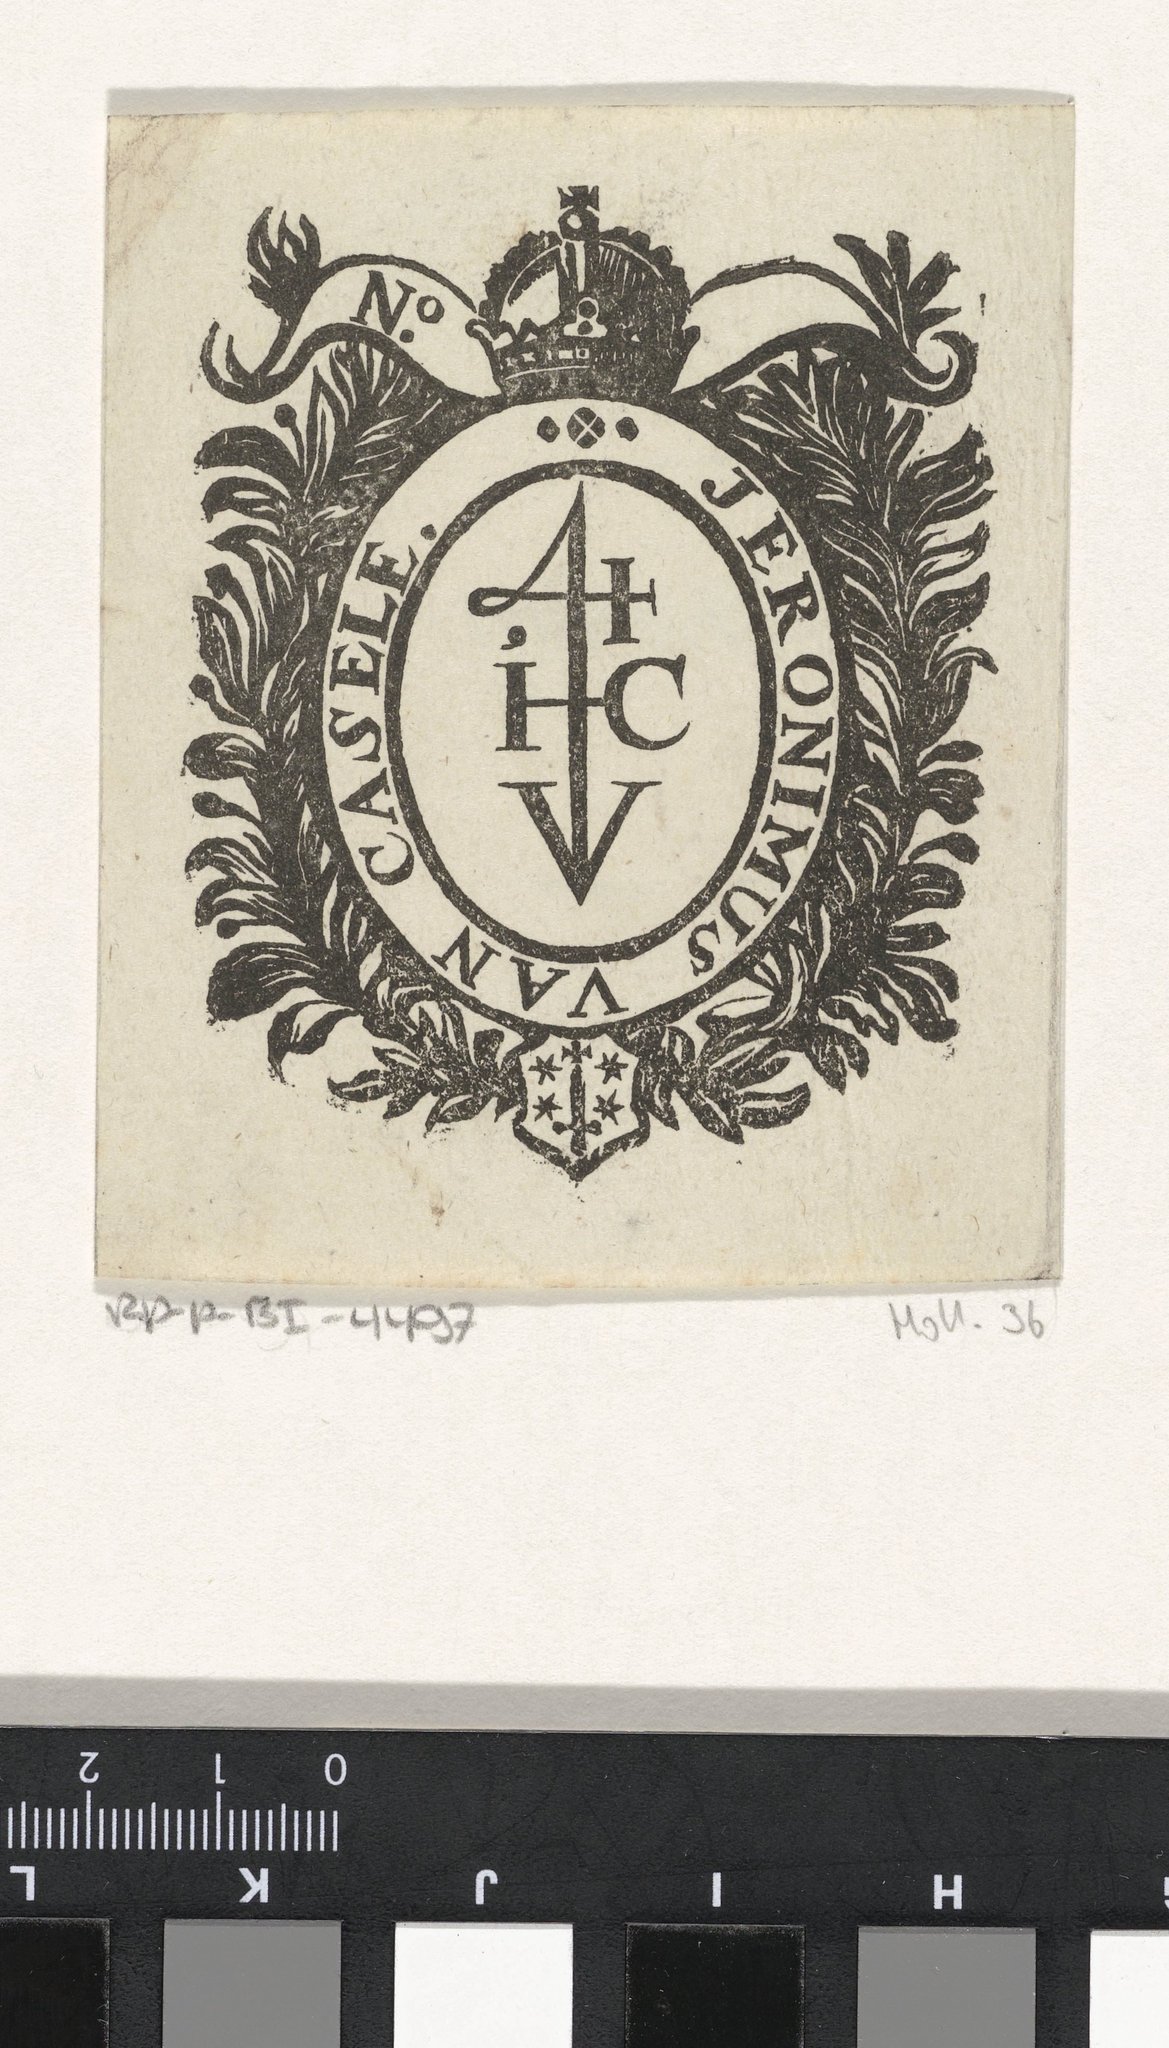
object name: handelsetiket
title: Handelsetiket van Jeronimus van Casele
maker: isaac vincentsz. van der vinne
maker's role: draughtsman, print maker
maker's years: 1665-1740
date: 1681-1740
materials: paper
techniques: woodcut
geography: haarlem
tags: coat of arms (as symbol of the state, etc.) (+ city; municipal), crown (symbol of sovereignty), vignette, letter combinations such as letterword, anagram, letter square, monogram, etc., haarlem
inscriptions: collector's mark: Lugt 240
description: Een handelsmerk van Jeronimus van Casele in een ovaal met randschrift. Midden boven een kroon, links daarvan 'No.', rechts daarvan ruimte om het nummer in te vullen. Midden onder het wapen van de stad Haarlem.